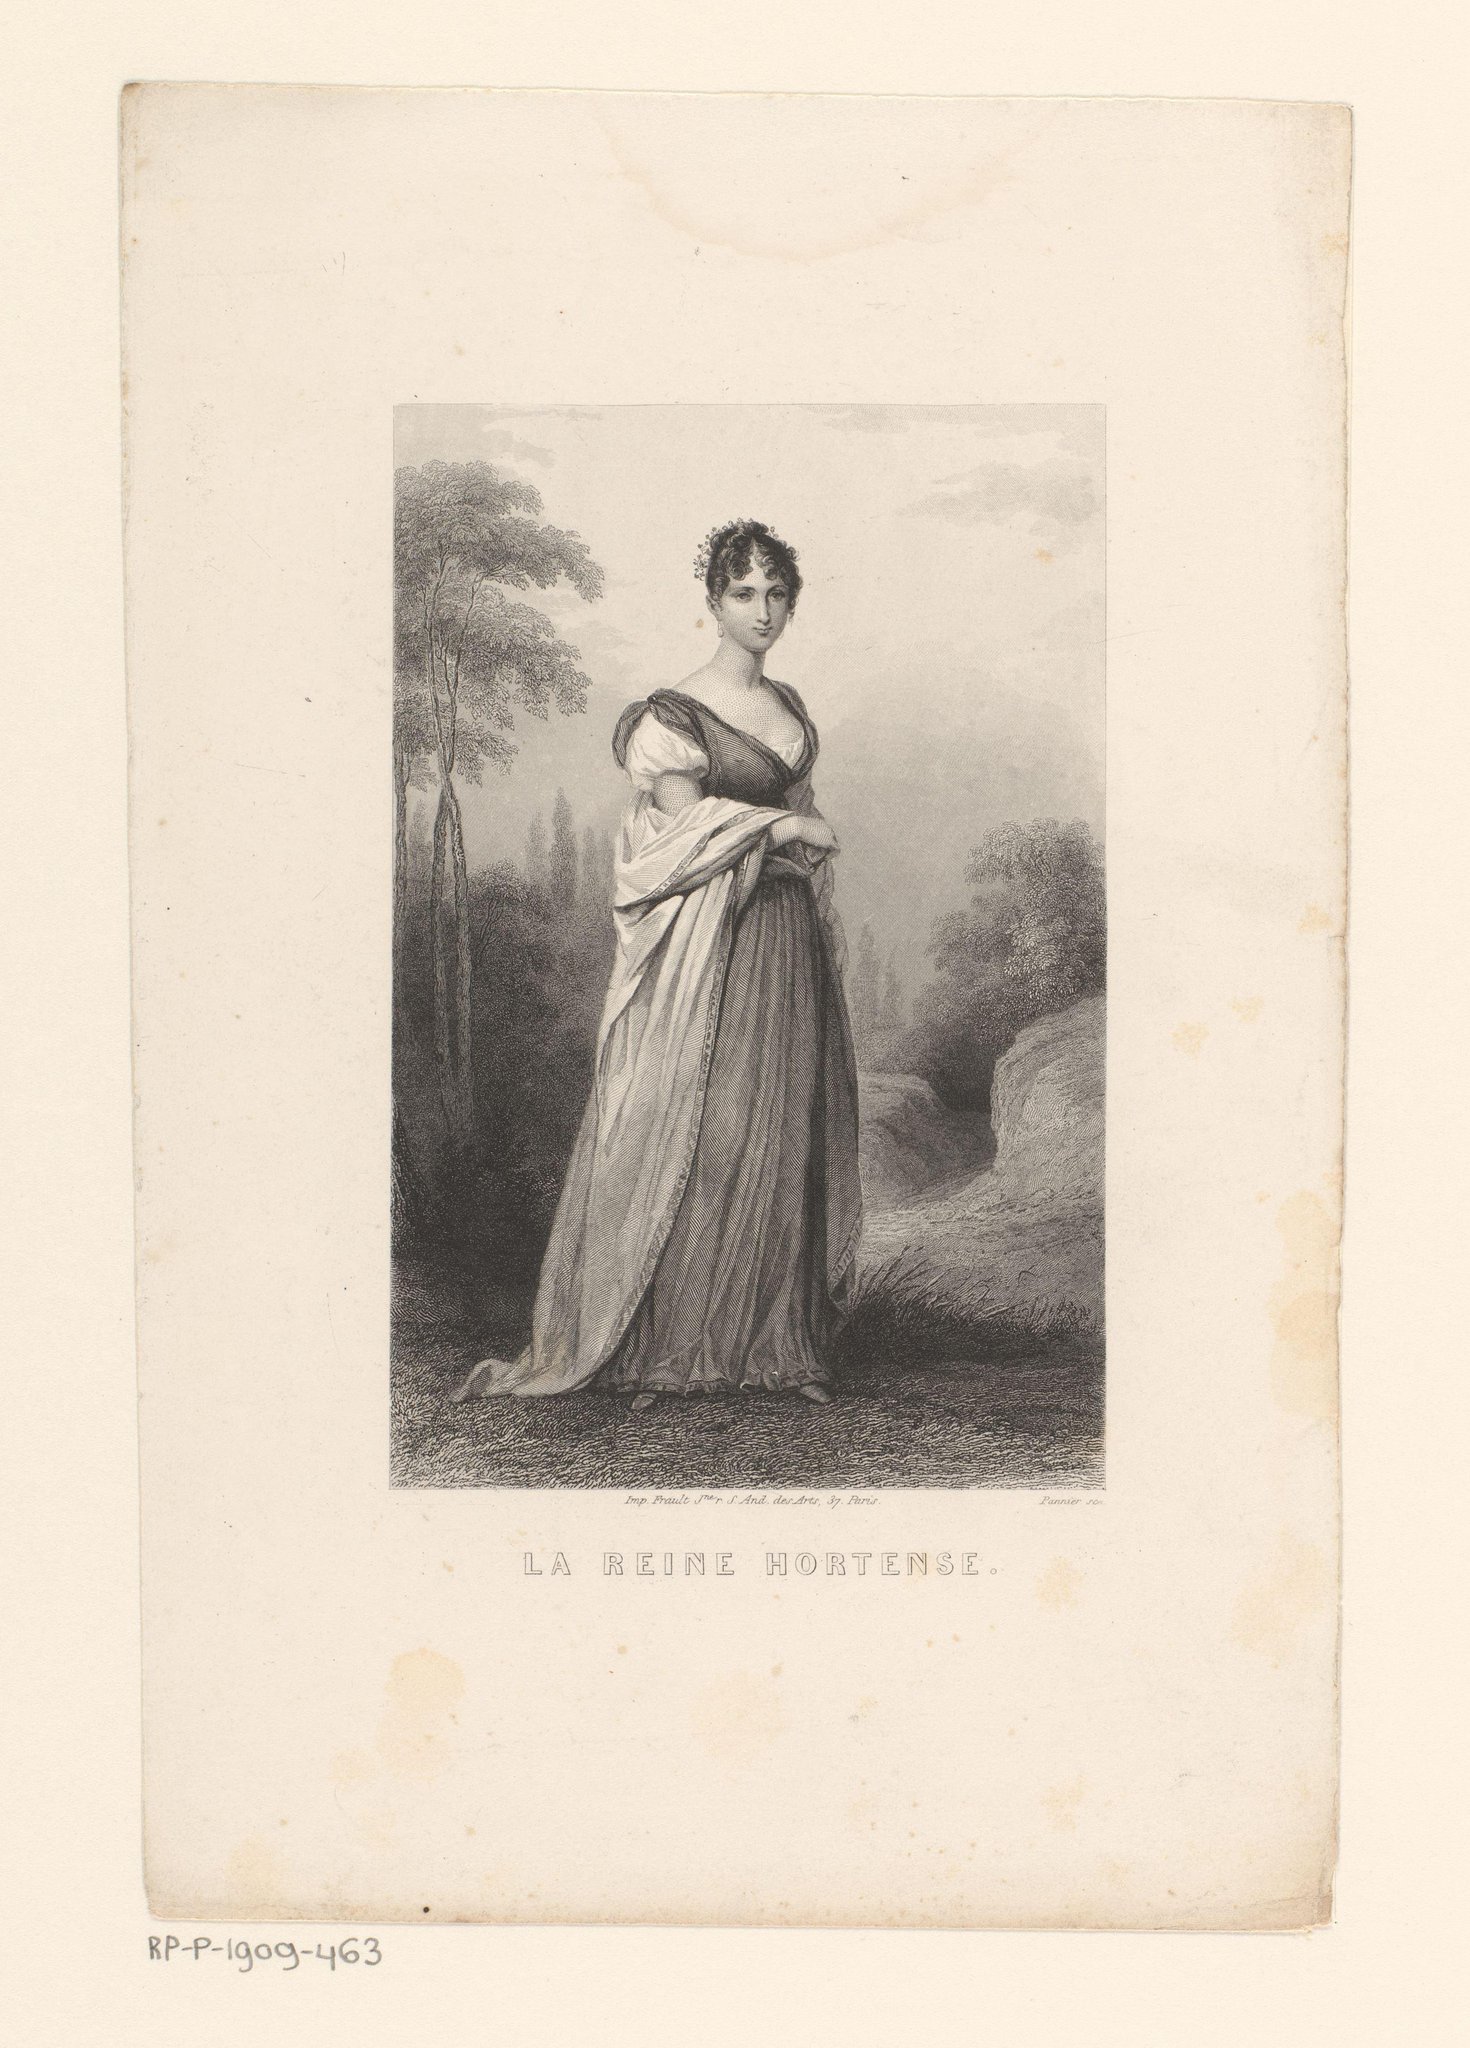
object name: print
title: Portret van Hortense Eugénie de Beauharnais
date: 1812-1869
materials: paper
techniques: engraving, etching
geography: paris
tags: historical persons - bb - woman, queen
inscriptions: collector's mark: Lugt 2228